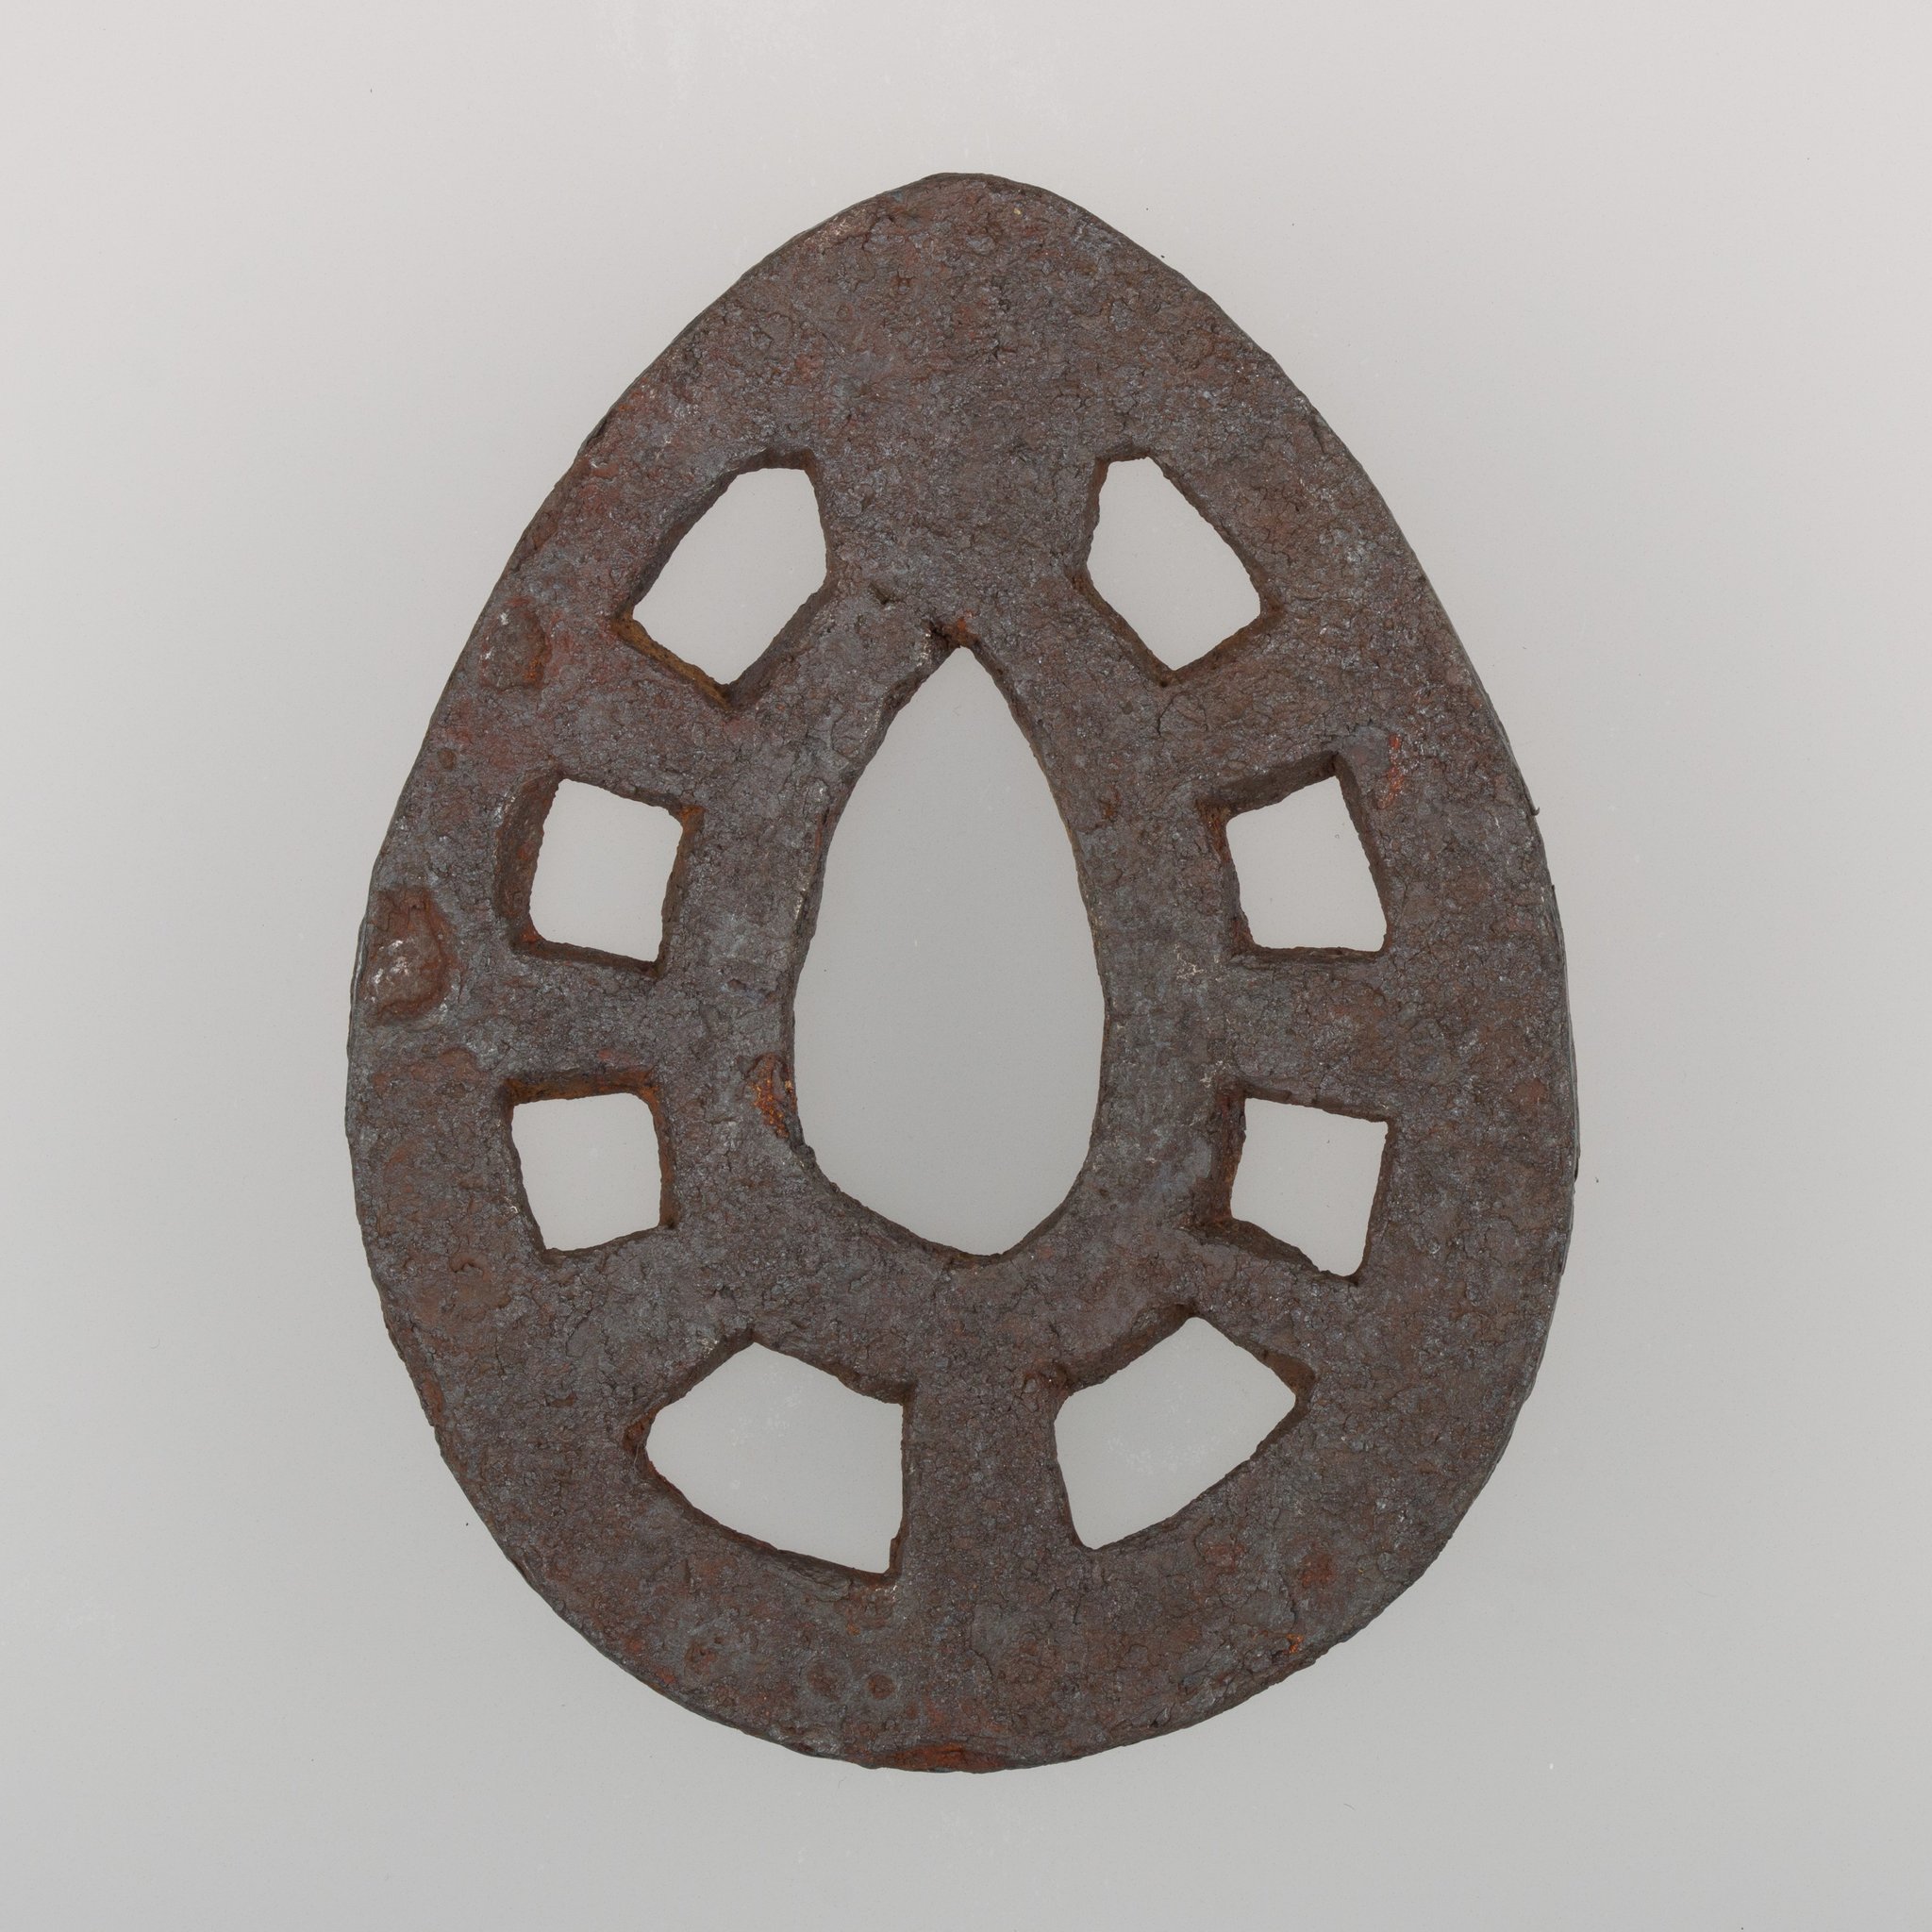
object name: sword guard tsuba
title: Sword Guard (Tsuba)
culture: japanese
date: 201-300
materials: iron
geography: japan